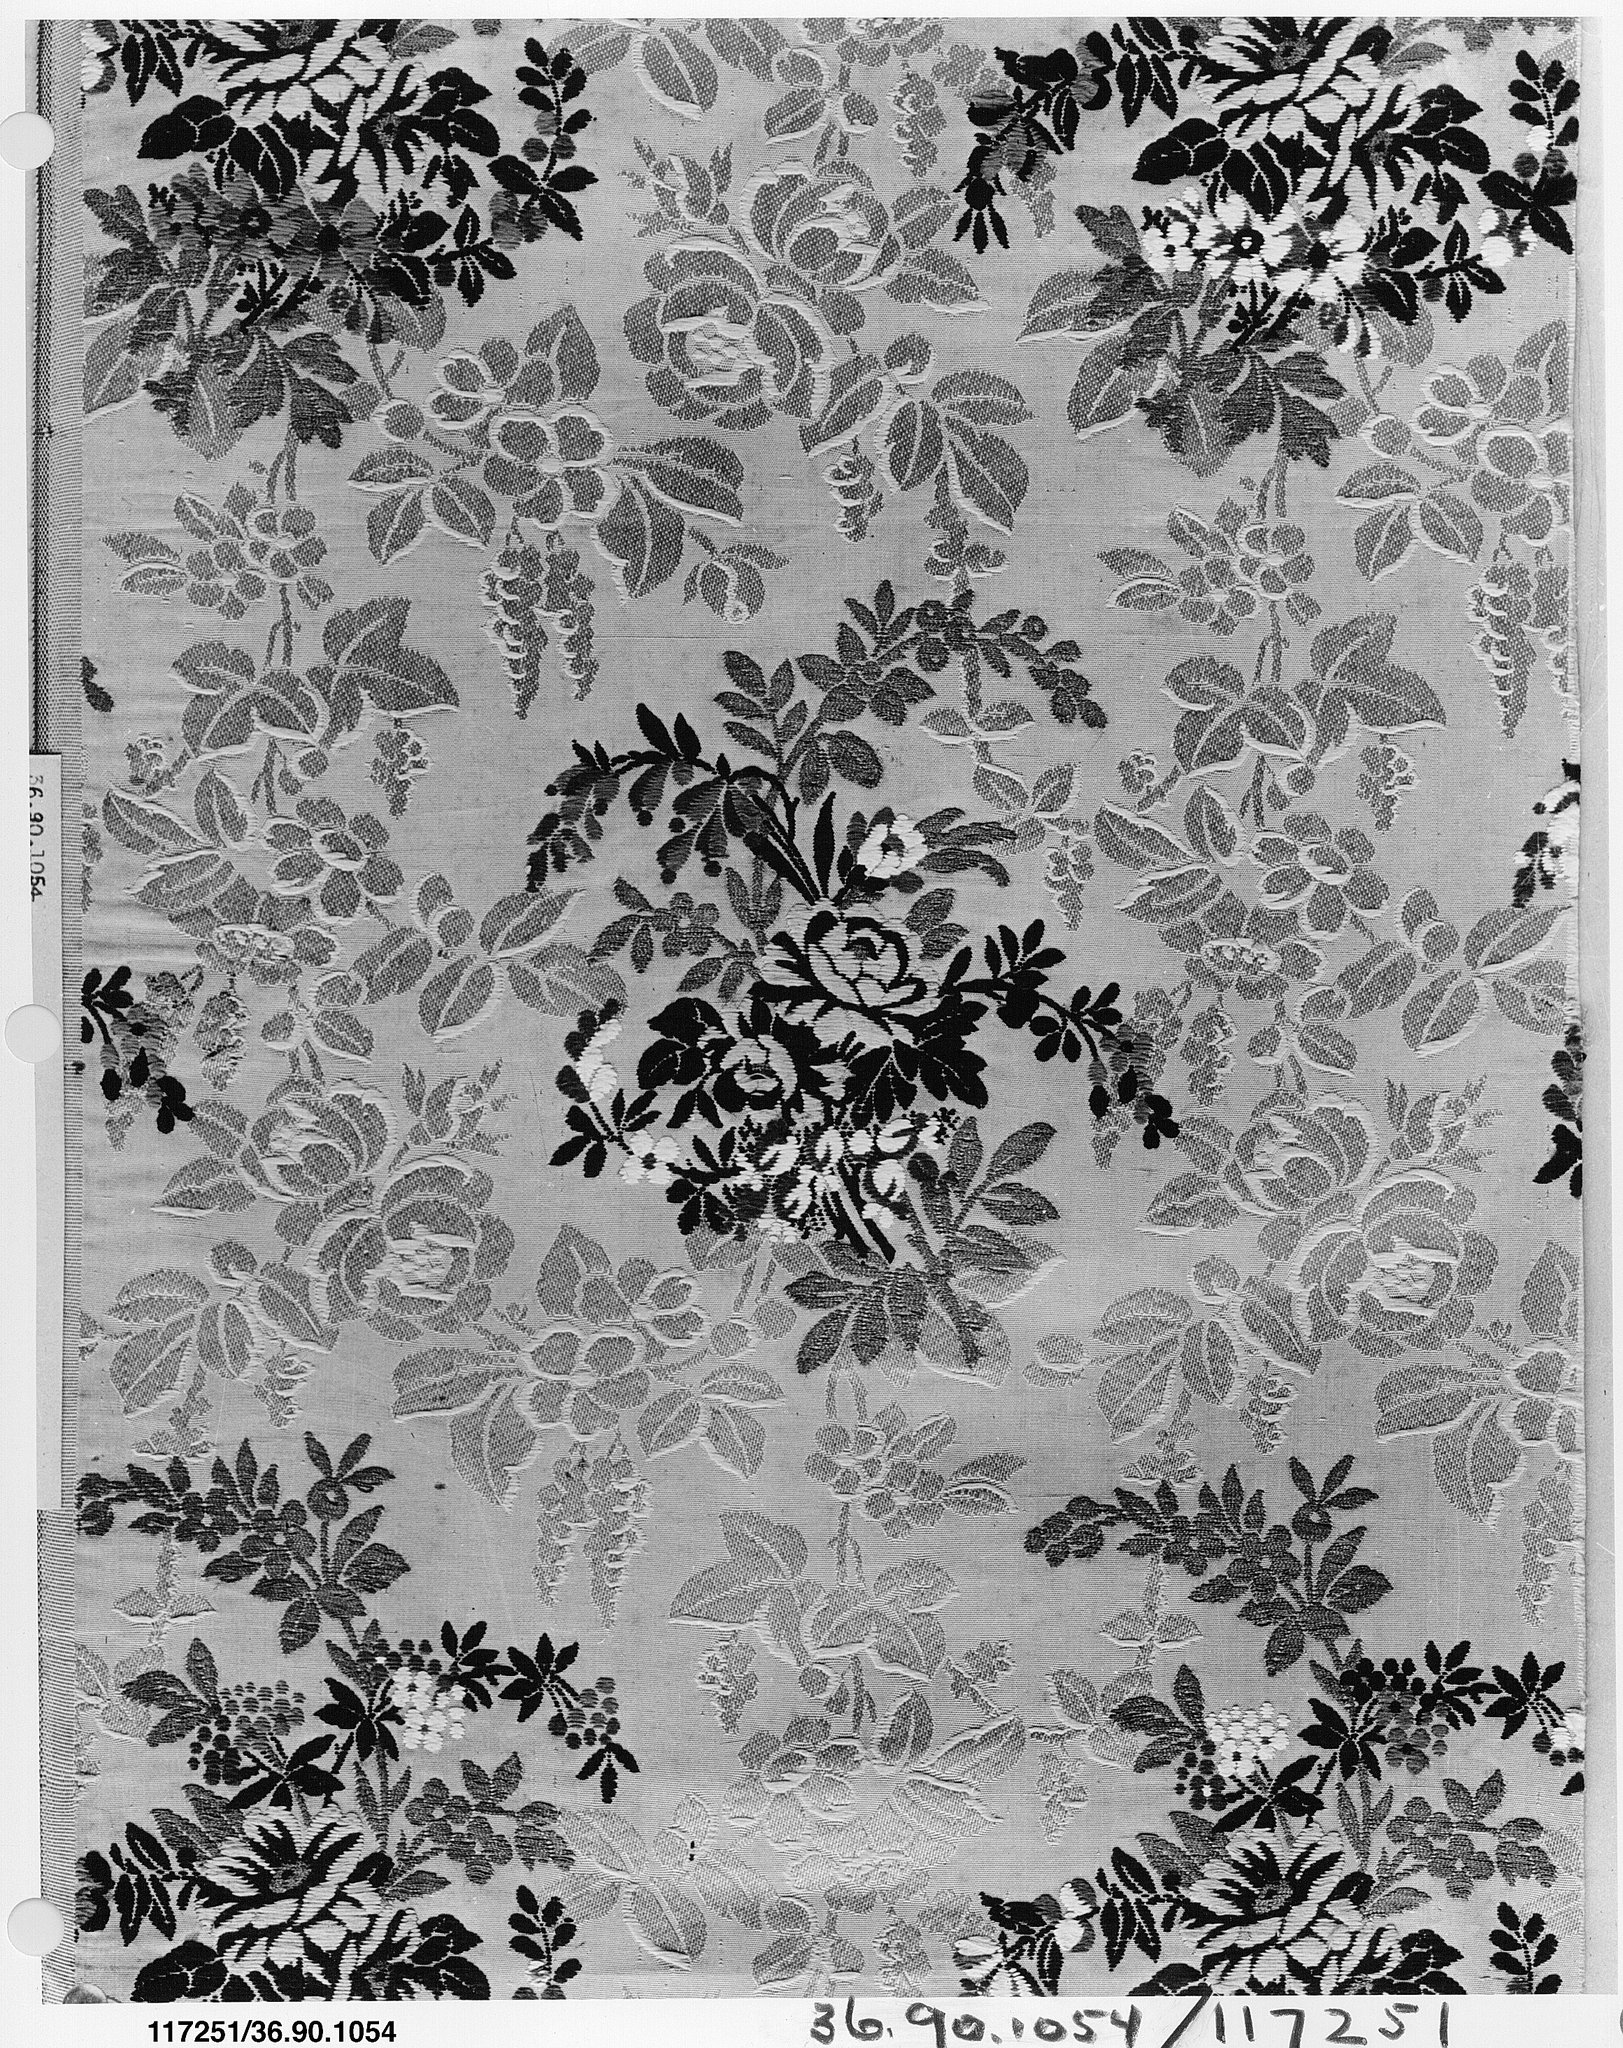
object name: piece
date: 1801-1900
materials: metal thread, silk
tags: flowers,leaves